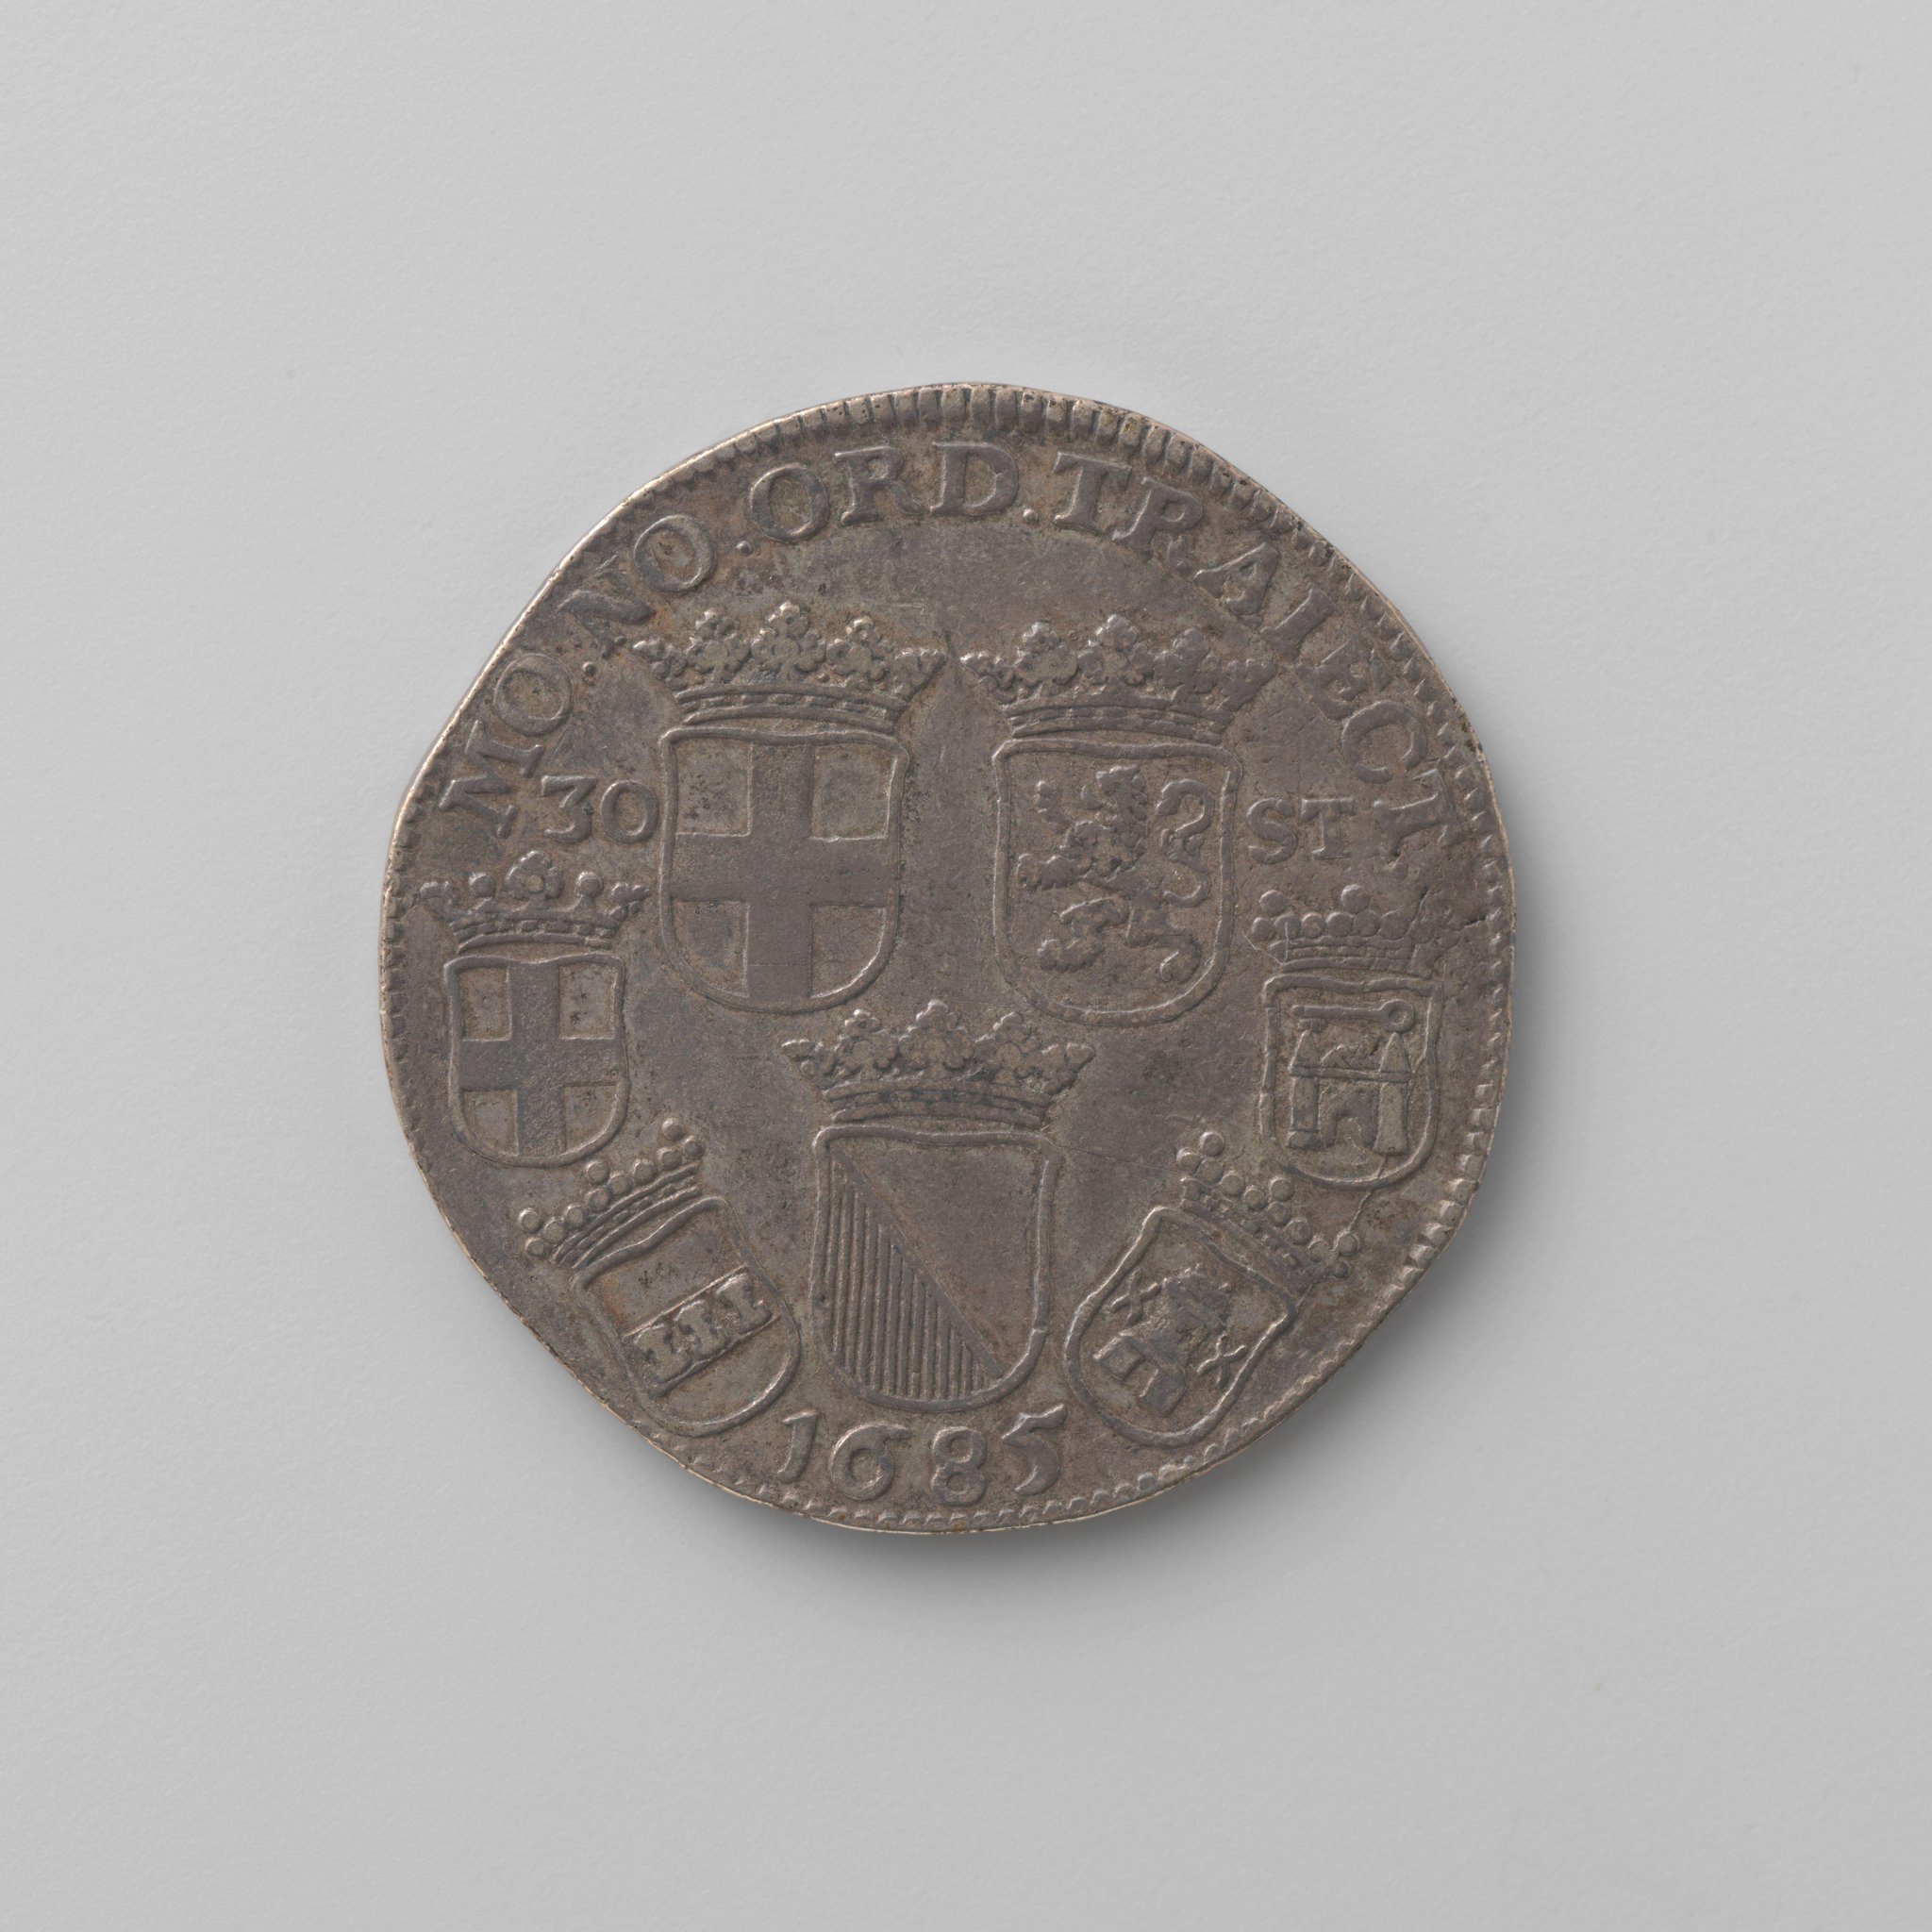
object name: coin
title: Utrecht, daalder, 1685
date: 1685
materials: silver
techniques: striking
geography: utrecht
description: Zilveren munt. Voorzijde: gekroond provinciewapenschild, gehouden door twee leeuwen. Keerzijde: zeven gekroonde wapenschilden met waarde-aanduiding 30 ST en jaartal.